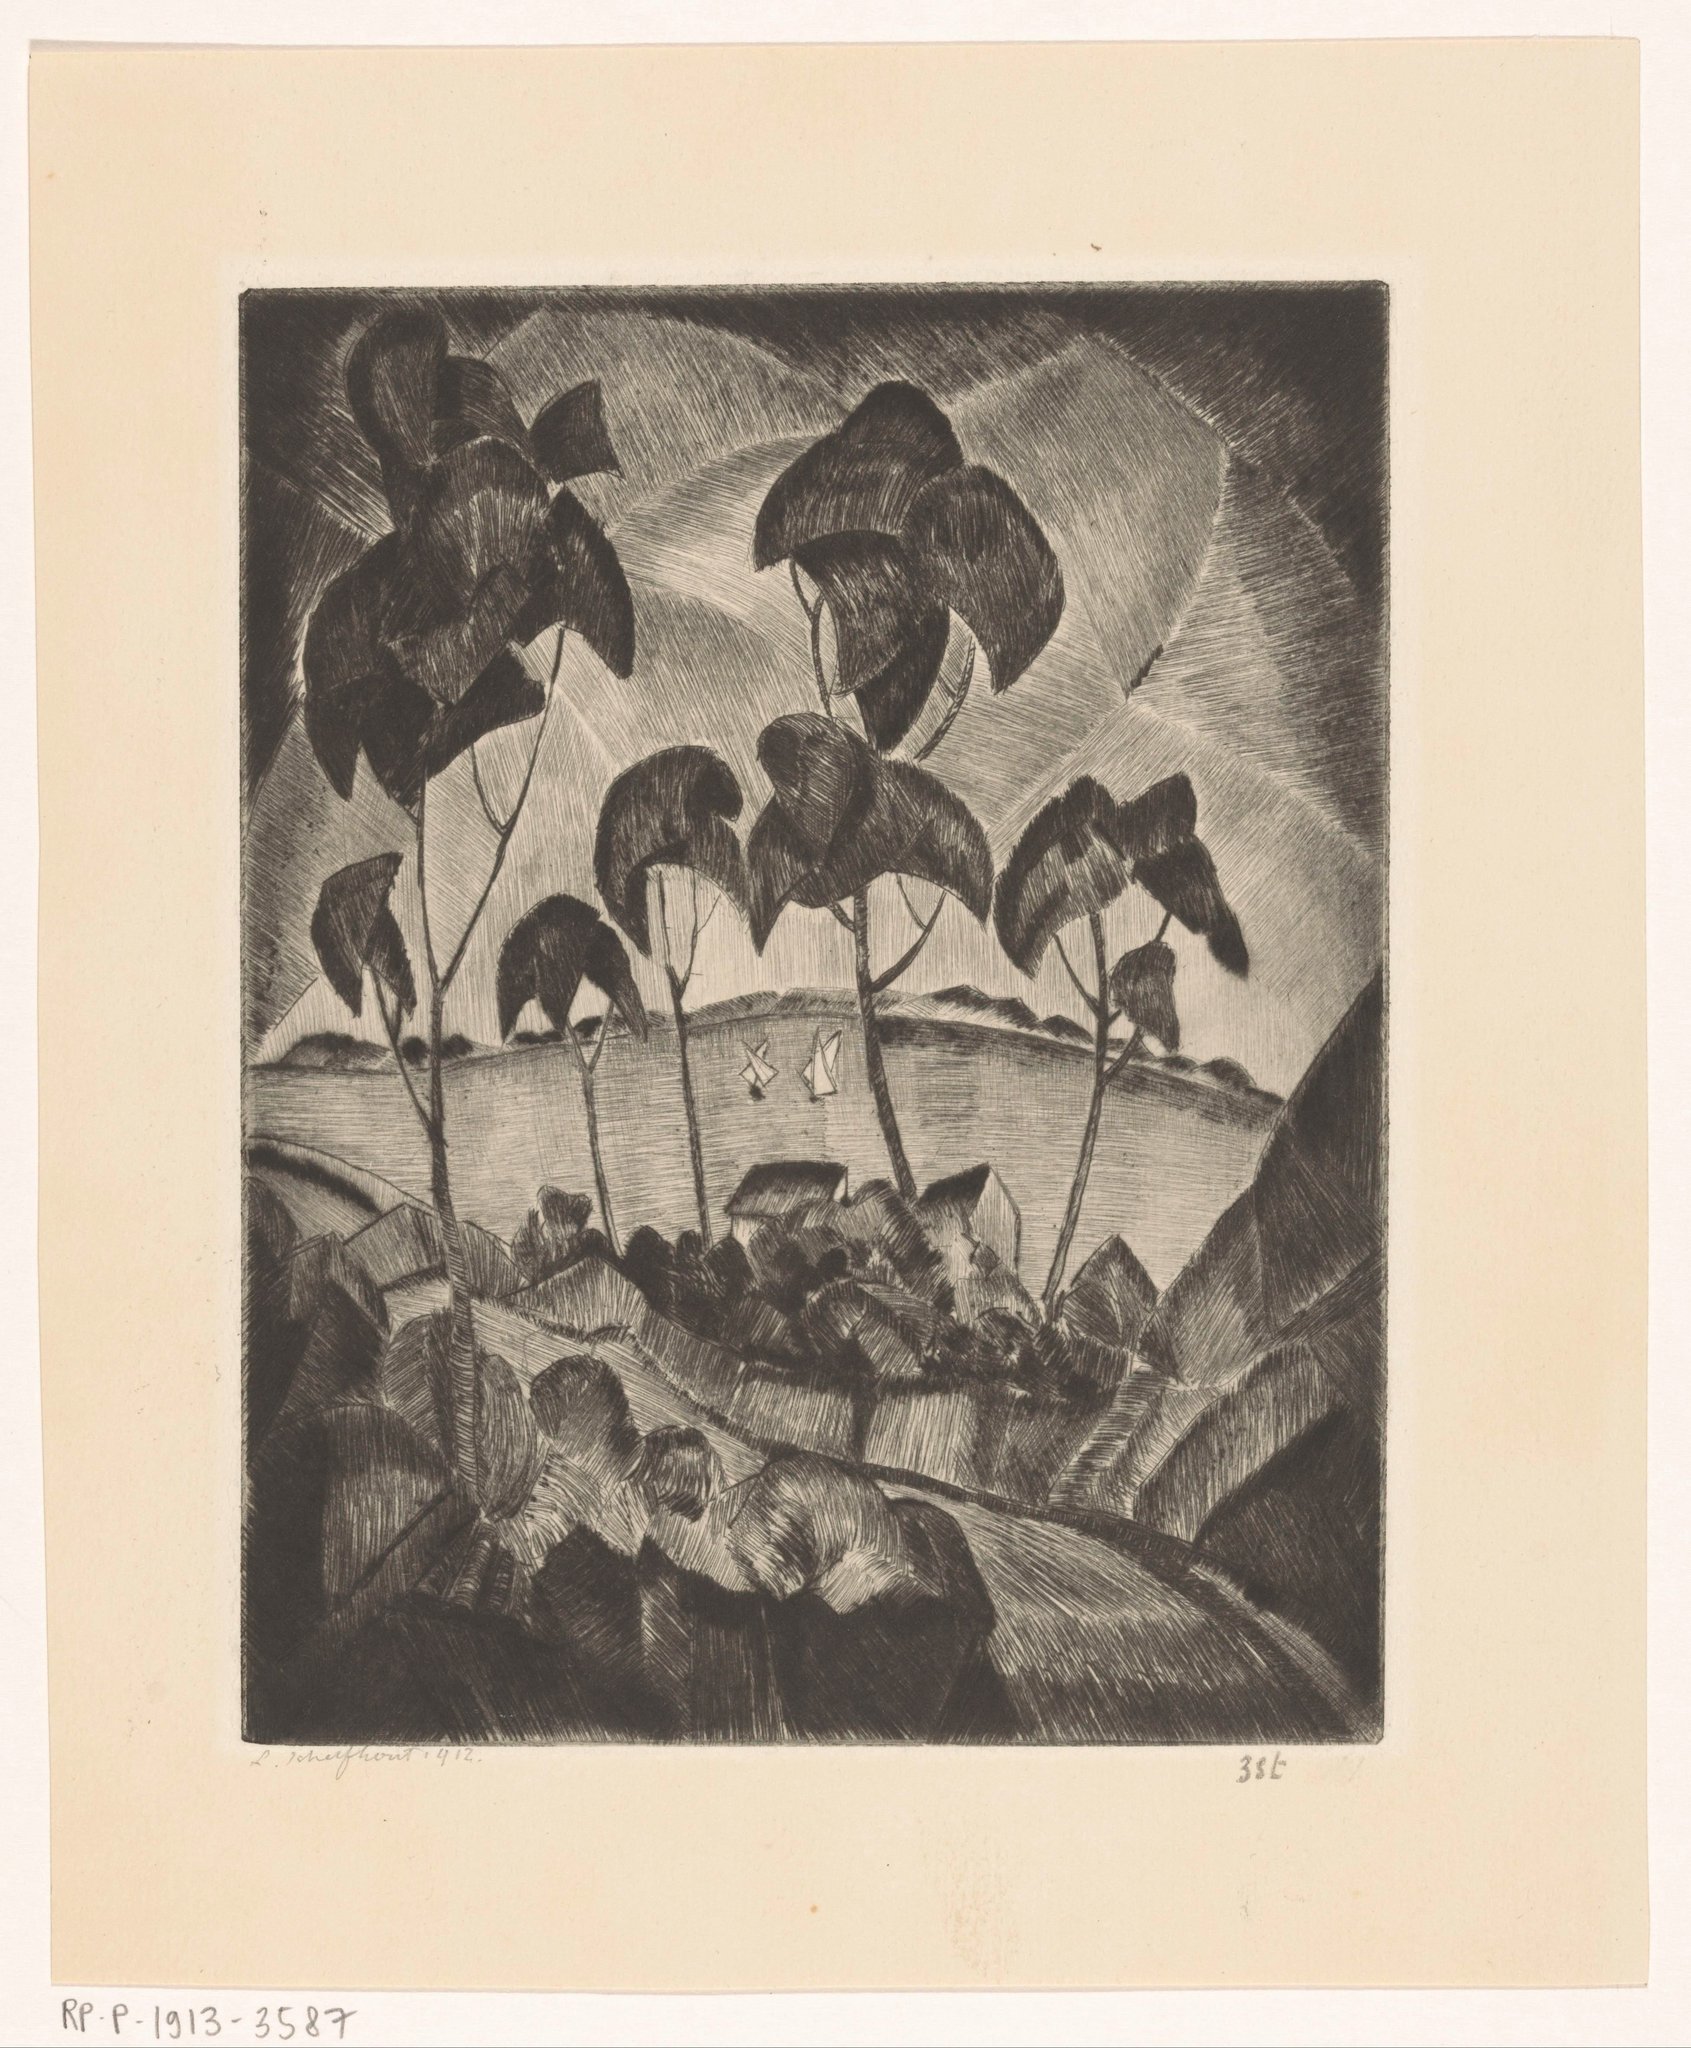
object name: print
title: Le Lac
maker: lodewijk schelfhout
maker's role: draughtsman, print maker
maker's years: 1881-1943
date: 1912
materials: paper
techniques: drypoint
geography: paris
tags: low hill country, lake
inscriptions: collector's mark: Lugt 2233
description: Zeilschepen op een meer in een heuvellandschap met bomen en huizen.